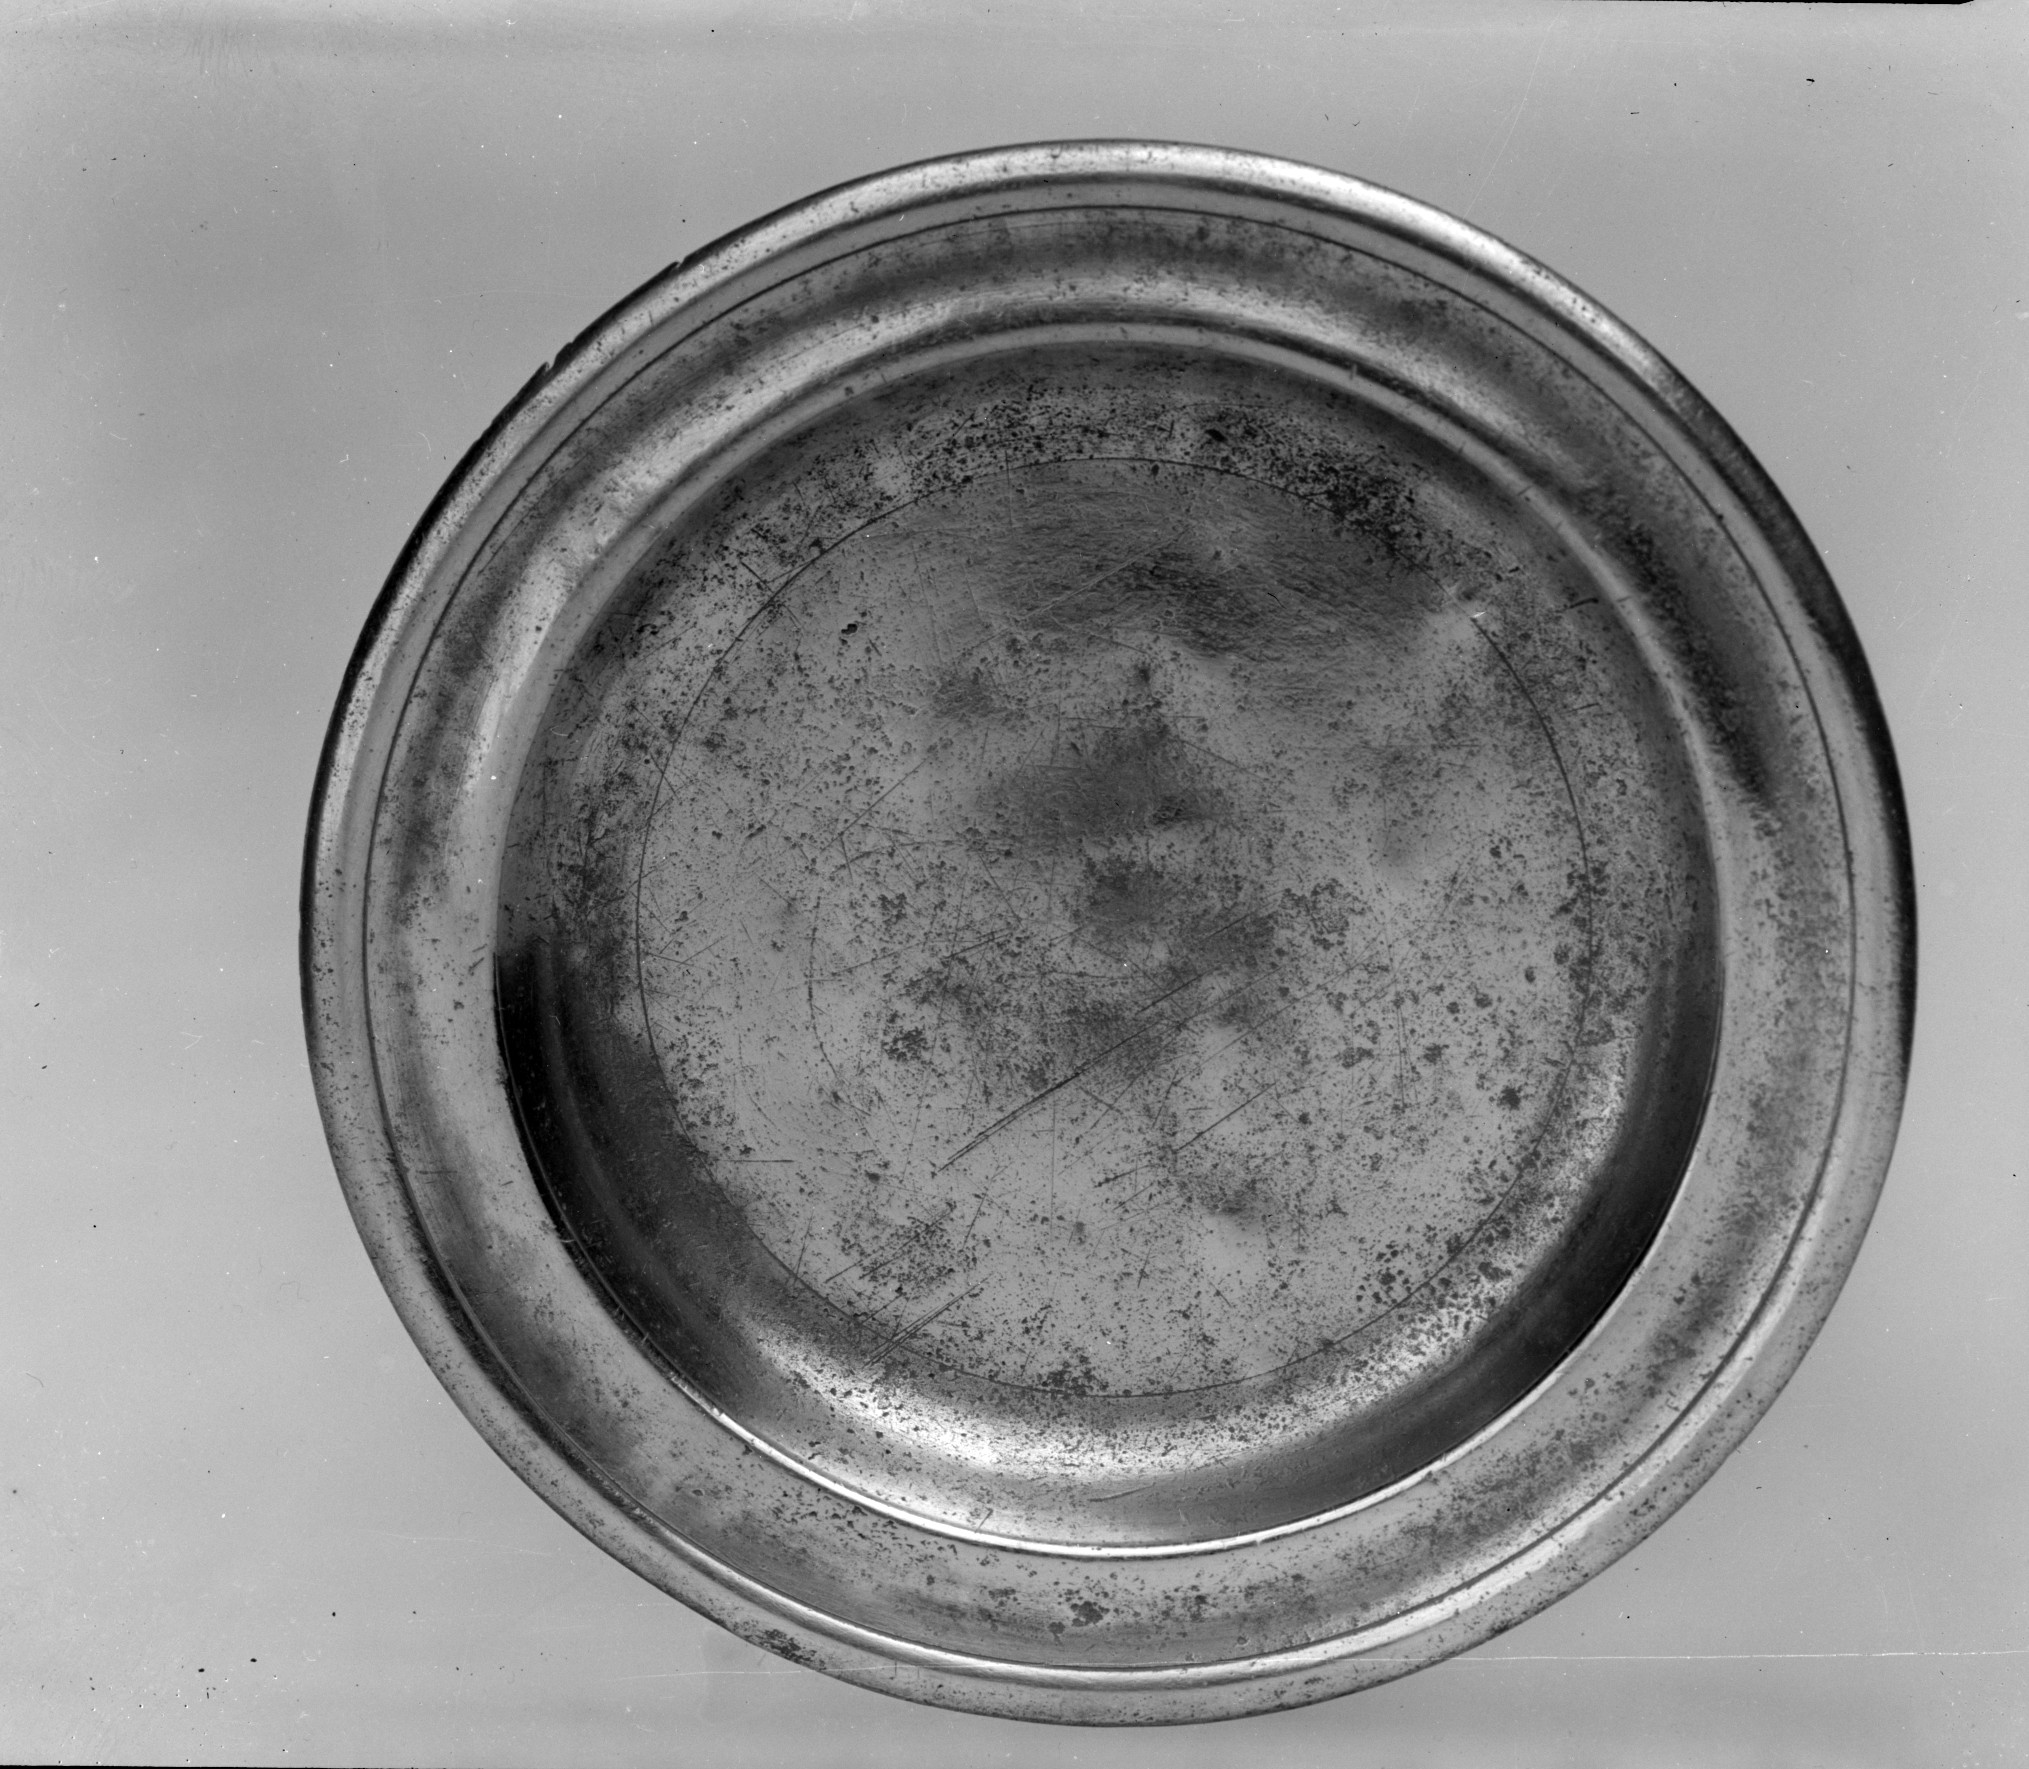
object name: plate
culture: american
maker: jacob whitmore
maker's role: maker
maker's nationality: american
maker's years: 1736-1825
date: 1758-1790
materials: pewter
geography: united states